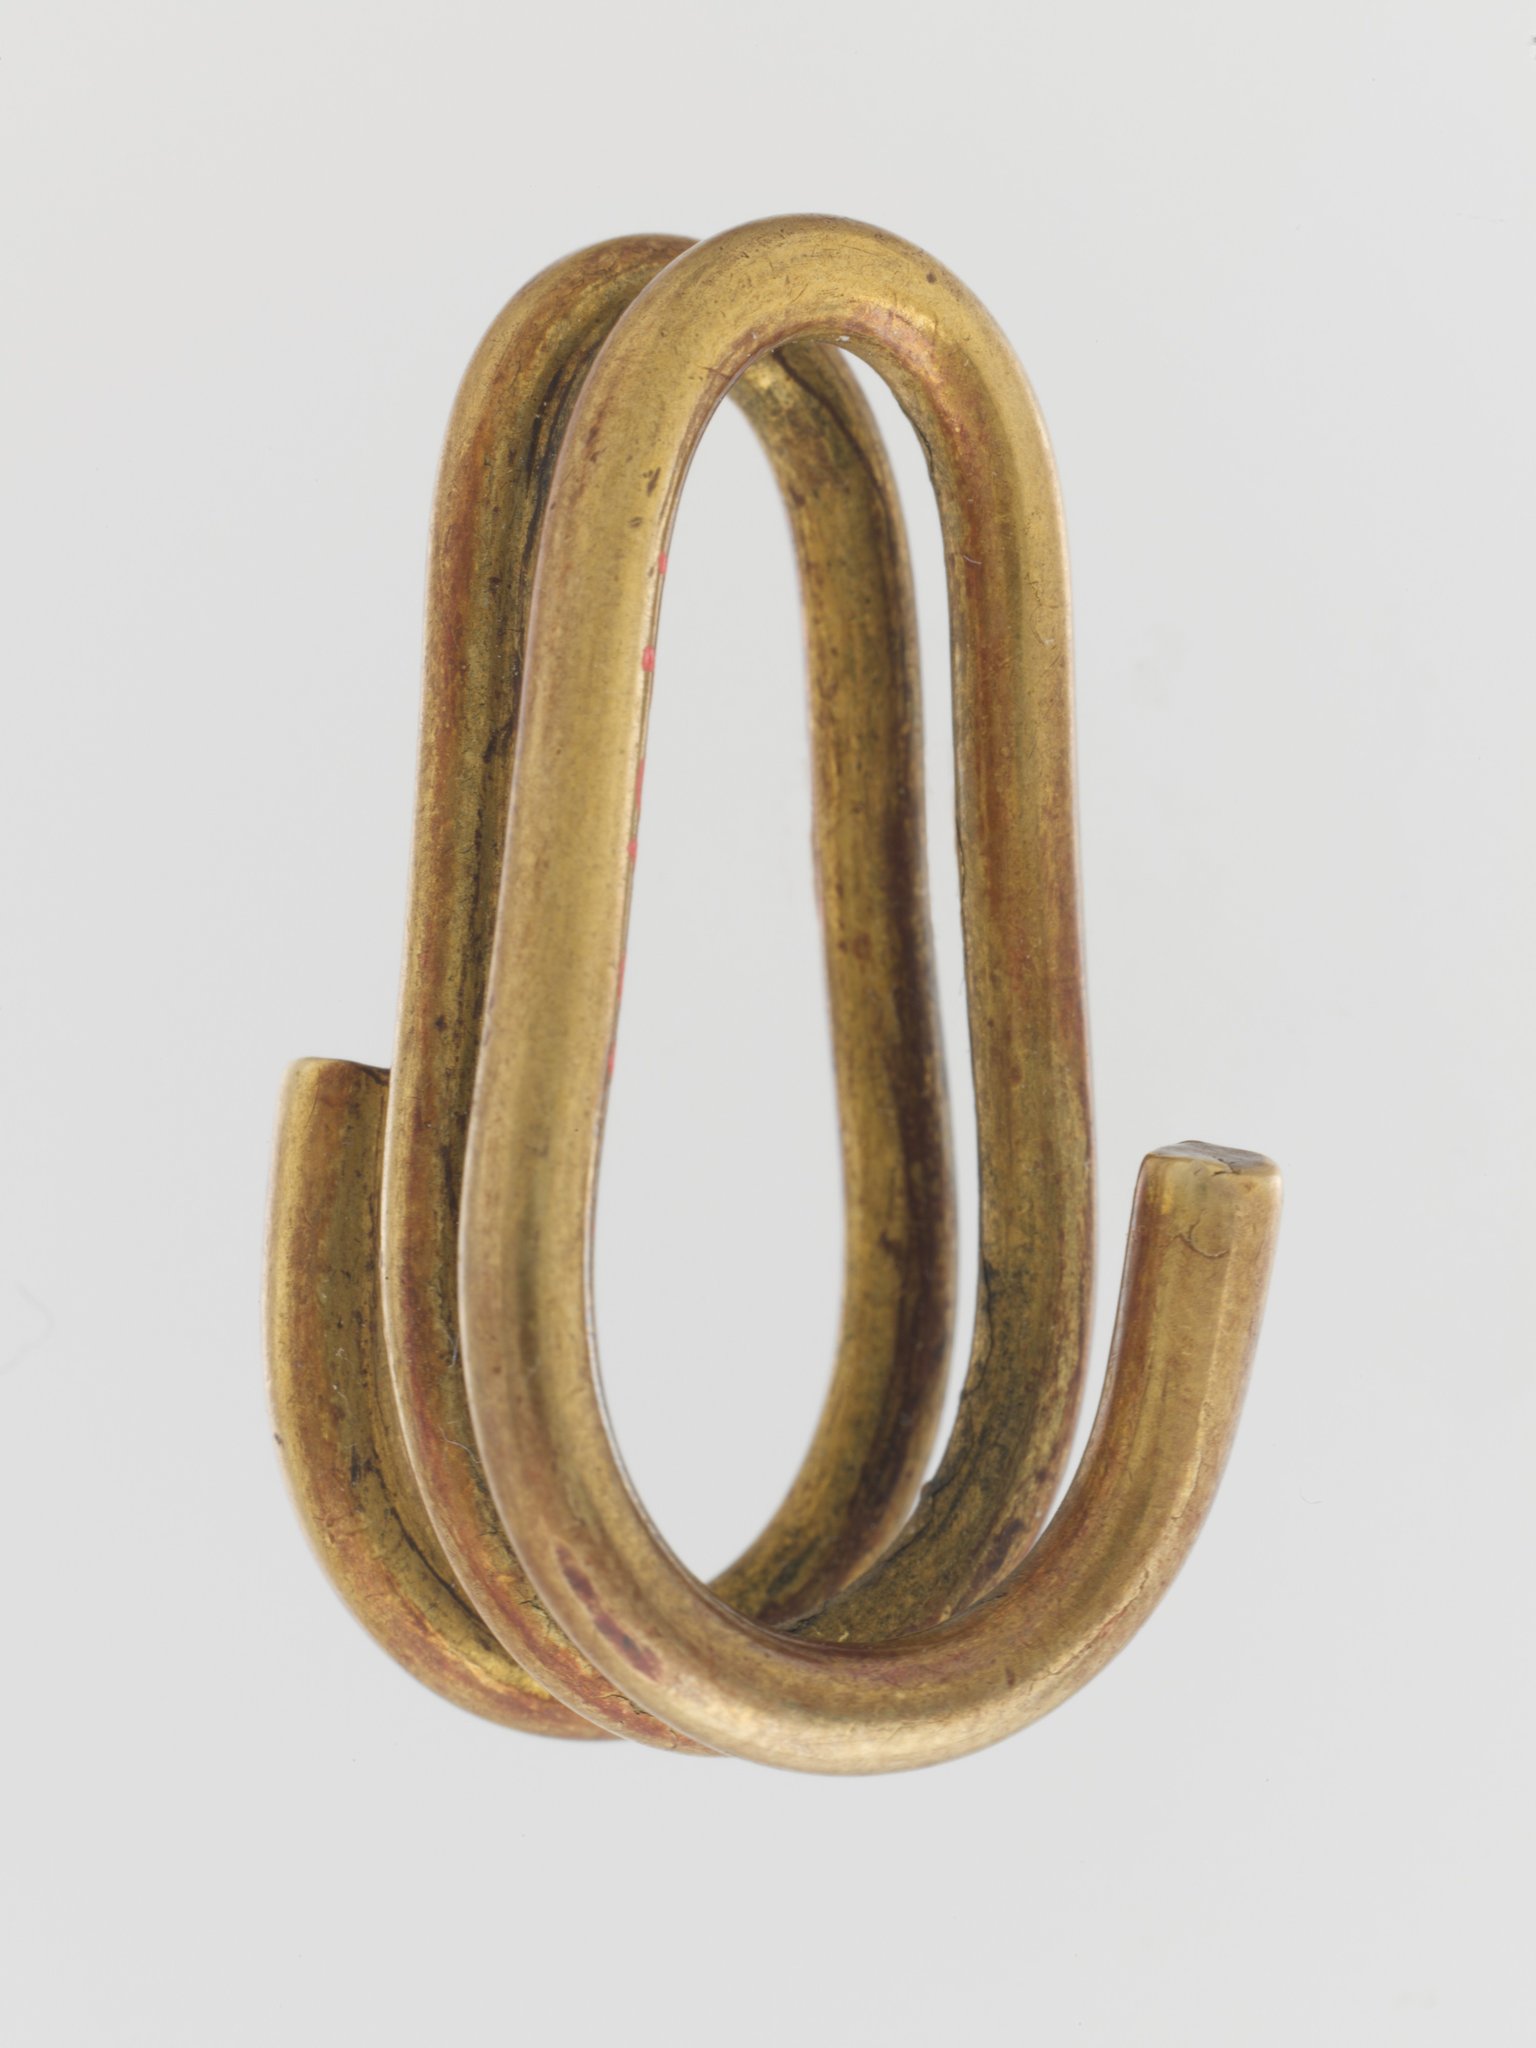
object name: earring or spiral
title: Gold spiral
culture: cypriot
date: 1600-1100 BCE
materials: gold